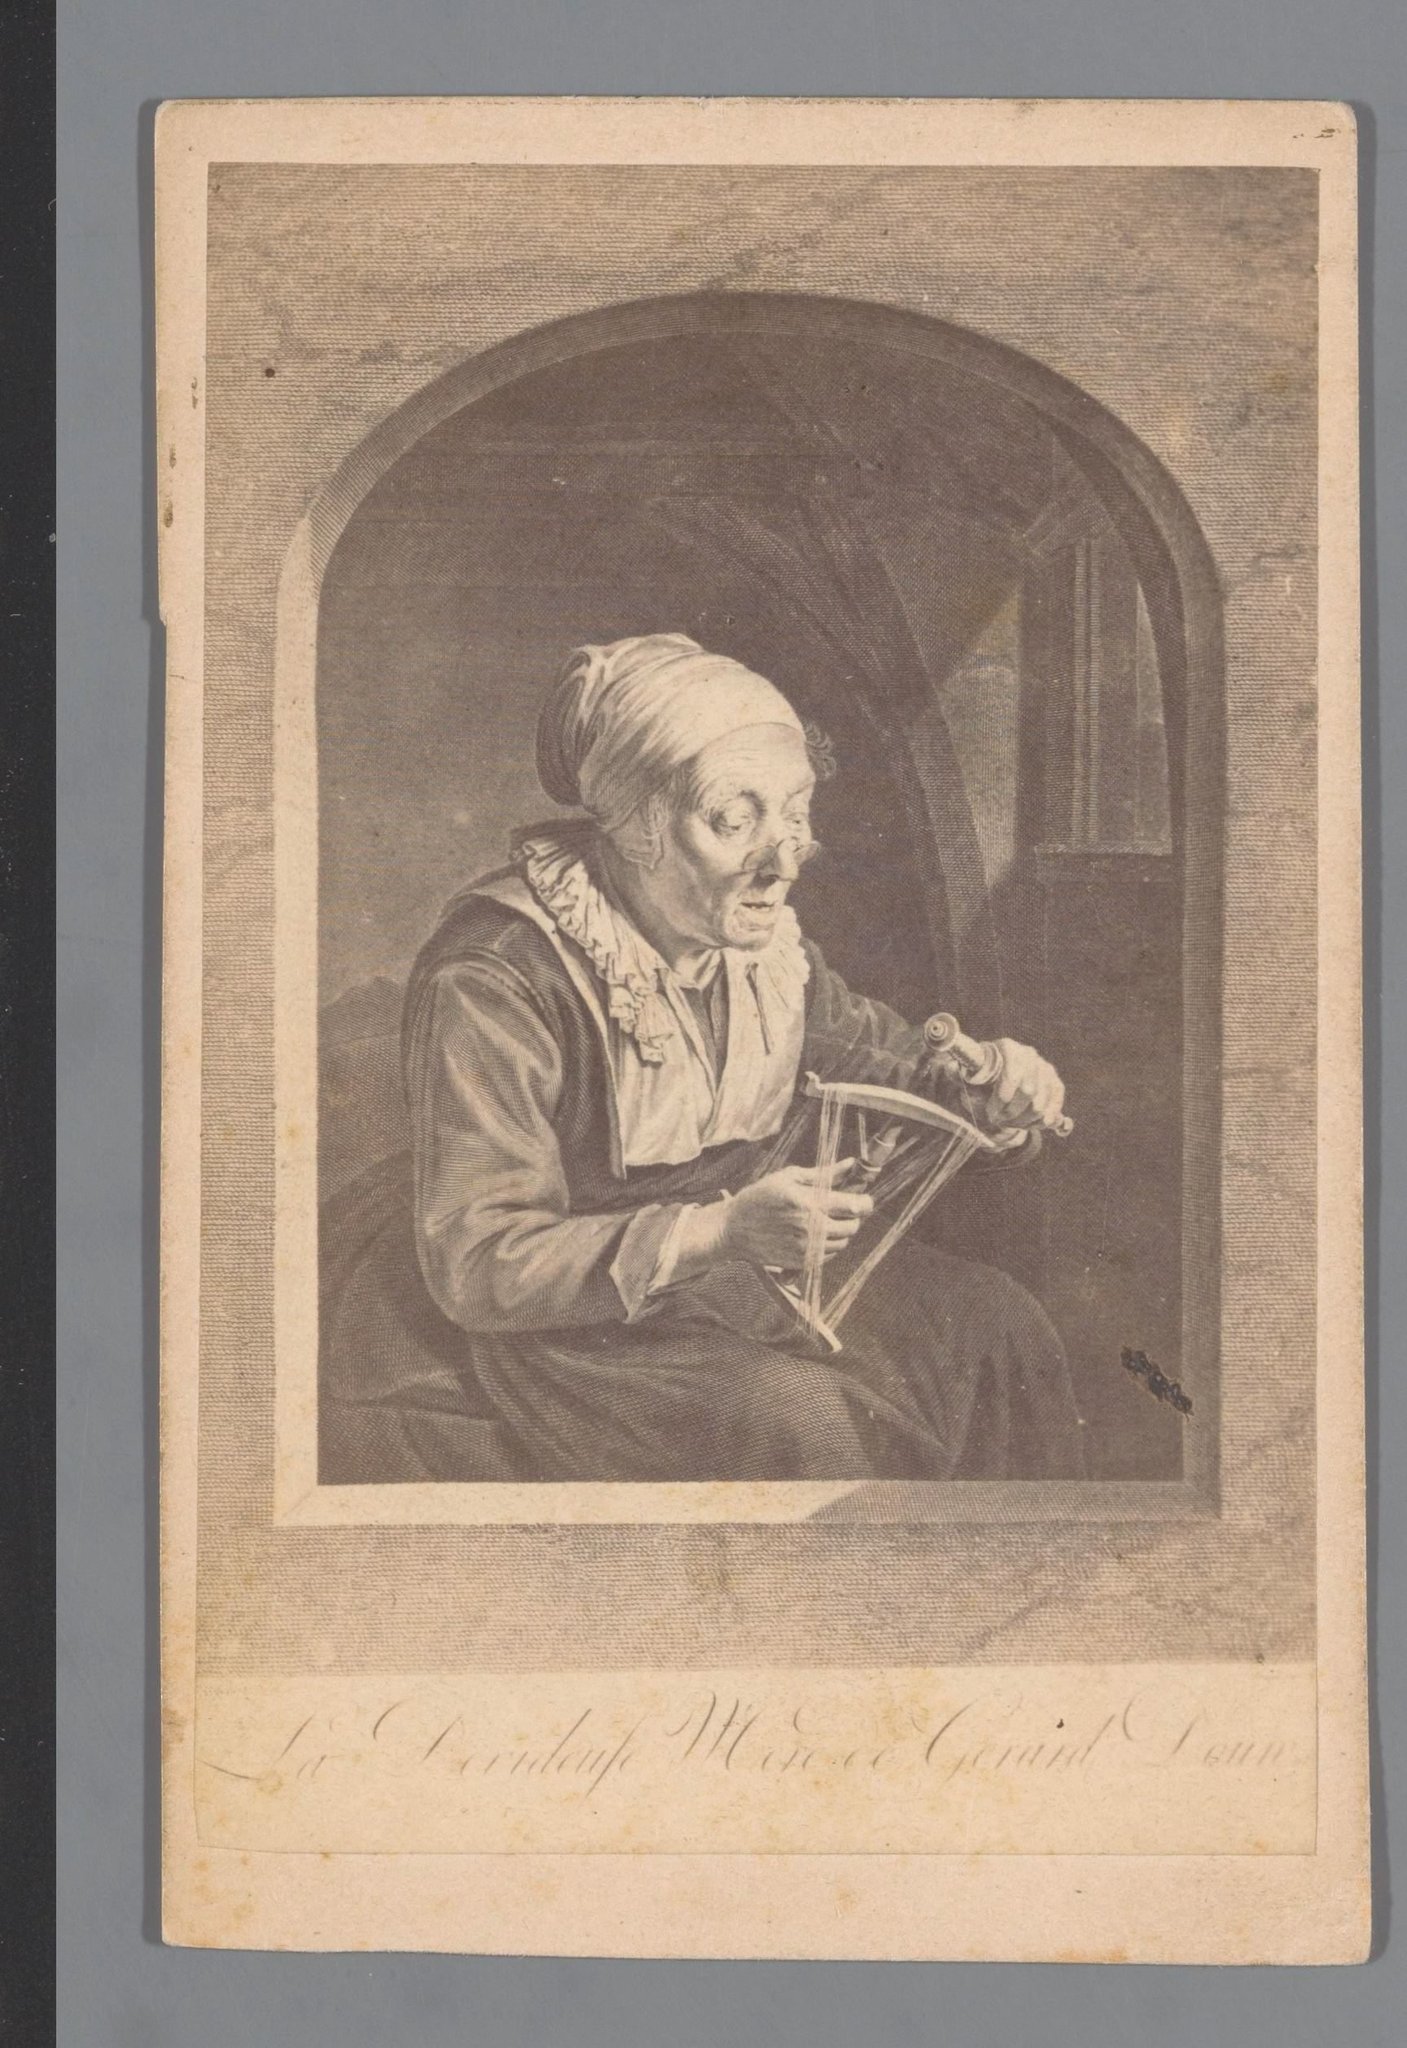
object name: reproduction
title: Fotoreproductie van een gravure naar een schilderij van een kantklossende vrouw, door Gerard Dou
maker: Anonymous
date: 1850-1900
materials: cardboard, photographic support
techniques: albumen print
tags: adult woman, manufacturing with yarn